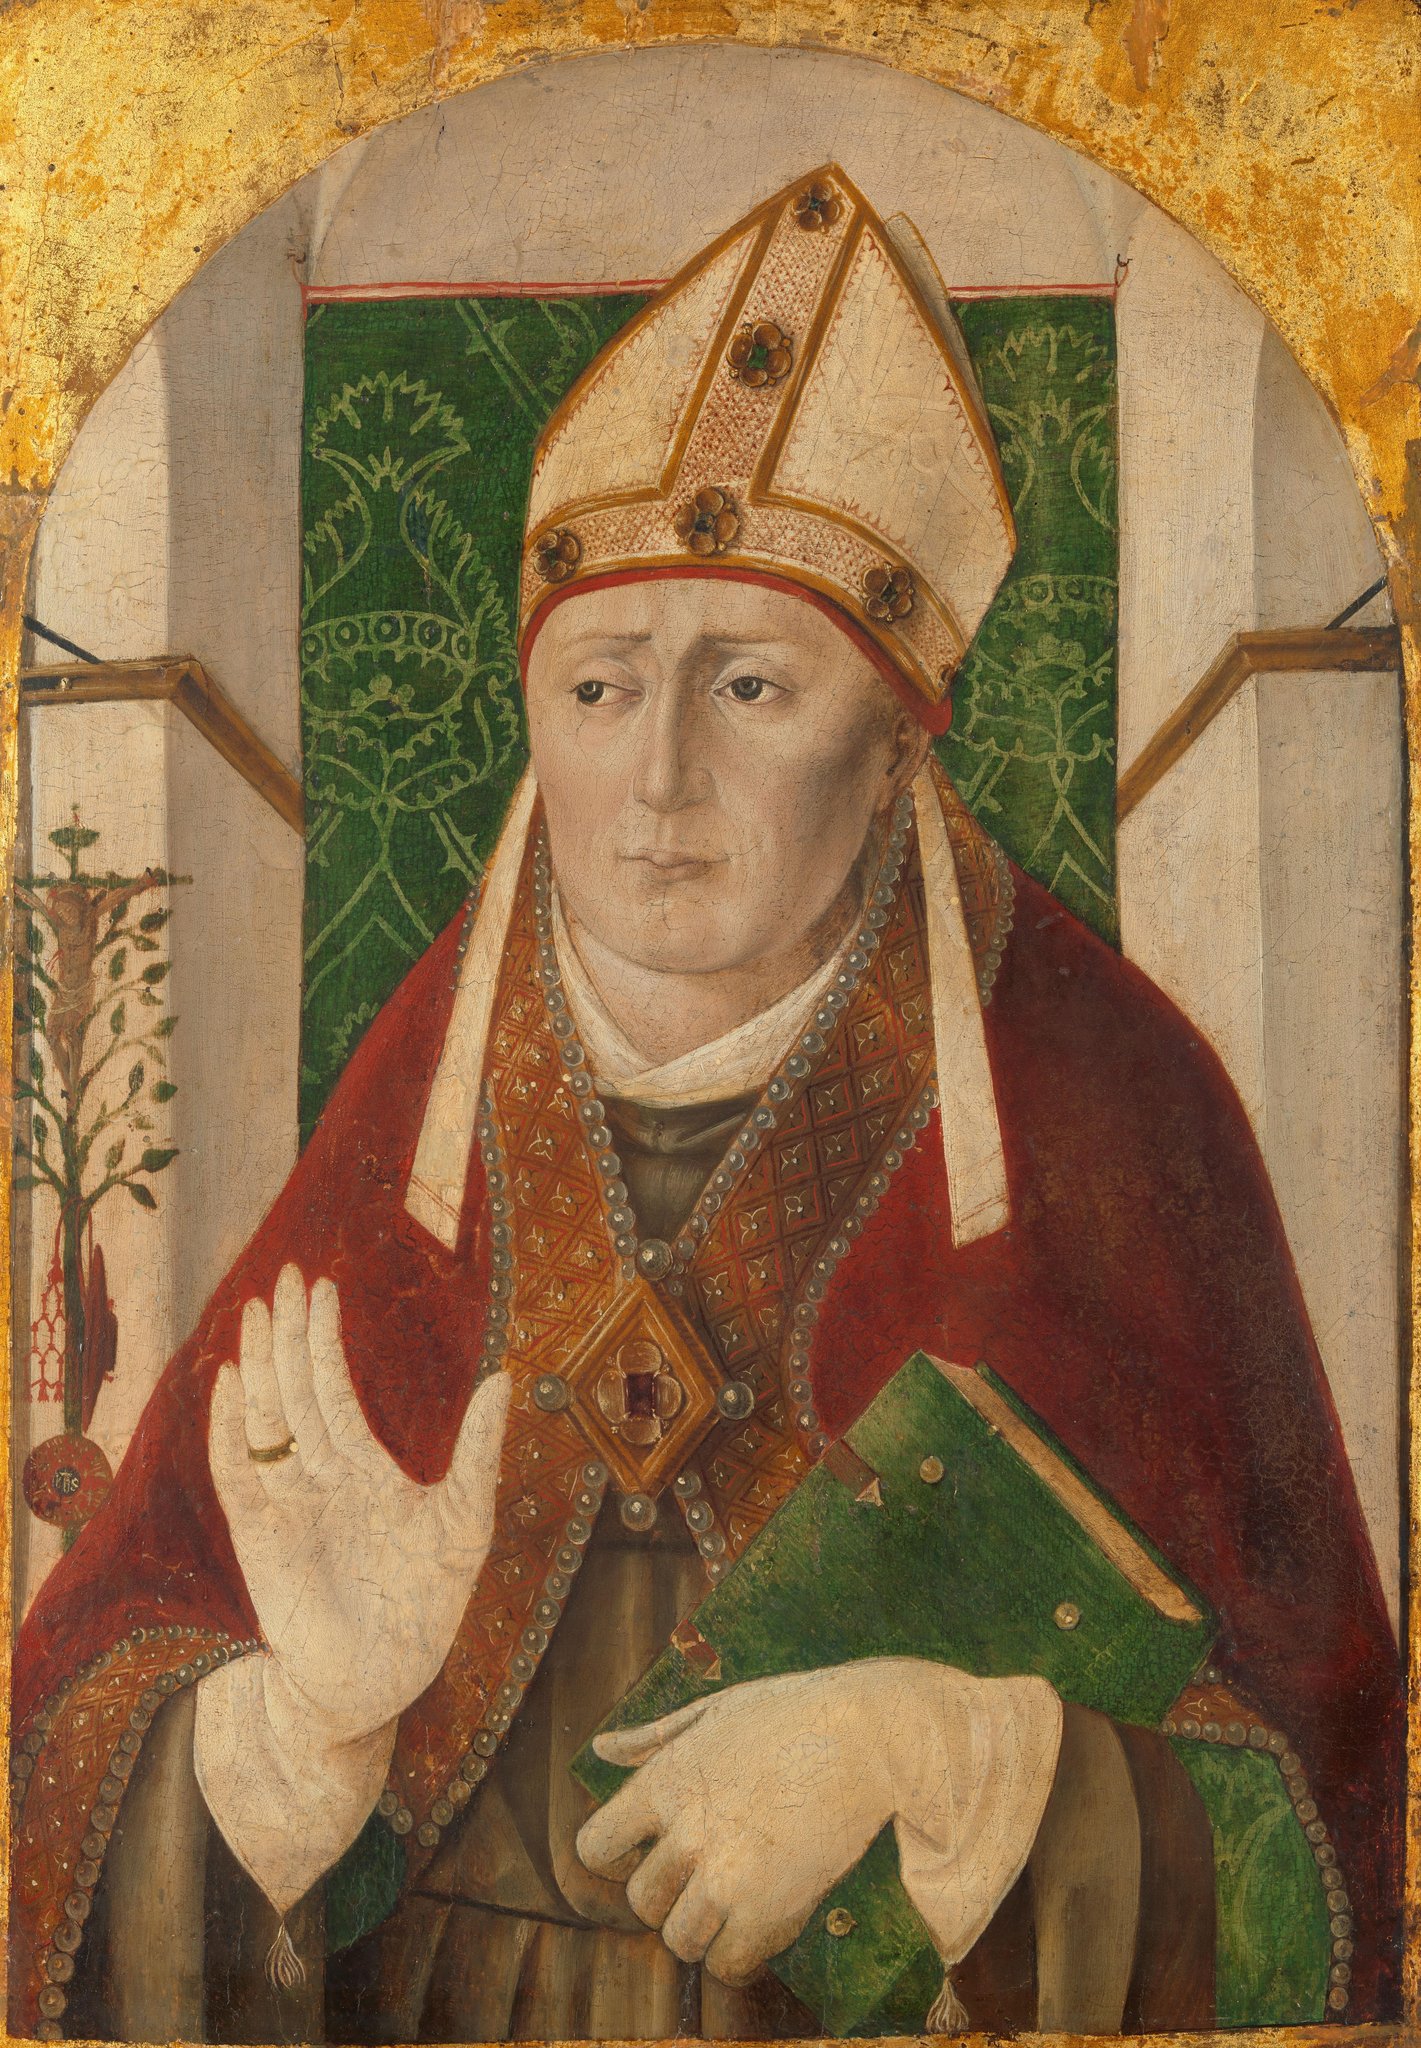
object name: painting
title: St Bonaventure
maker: girolamo da treviso i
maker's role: painter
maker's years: 1450-1497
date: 1490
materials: oil, panel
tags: bonaventura, cardinal bishop of albano and minister general of the franciscan order; possible attributes: book, cardinal's hat (sometimes hanging from a tree), crucifix (sometimes flowering)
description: De heilige Bonaventura. Halffiguur met boek in de linkerhand en opgestoken rechterhand.